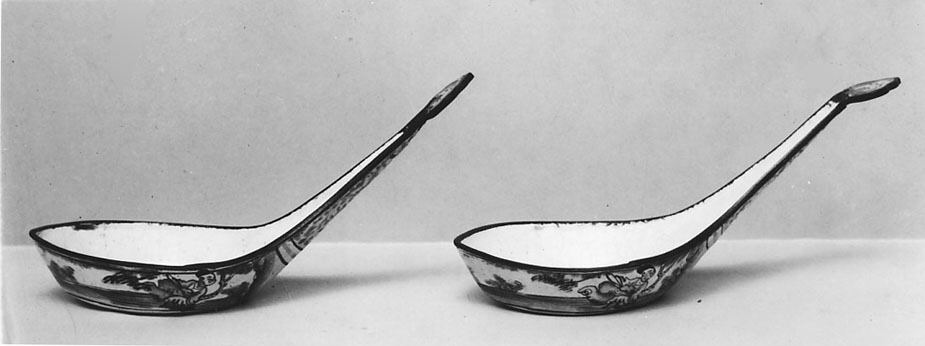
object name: spoon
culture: chinese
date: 1801-1900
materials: enamel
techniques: painting